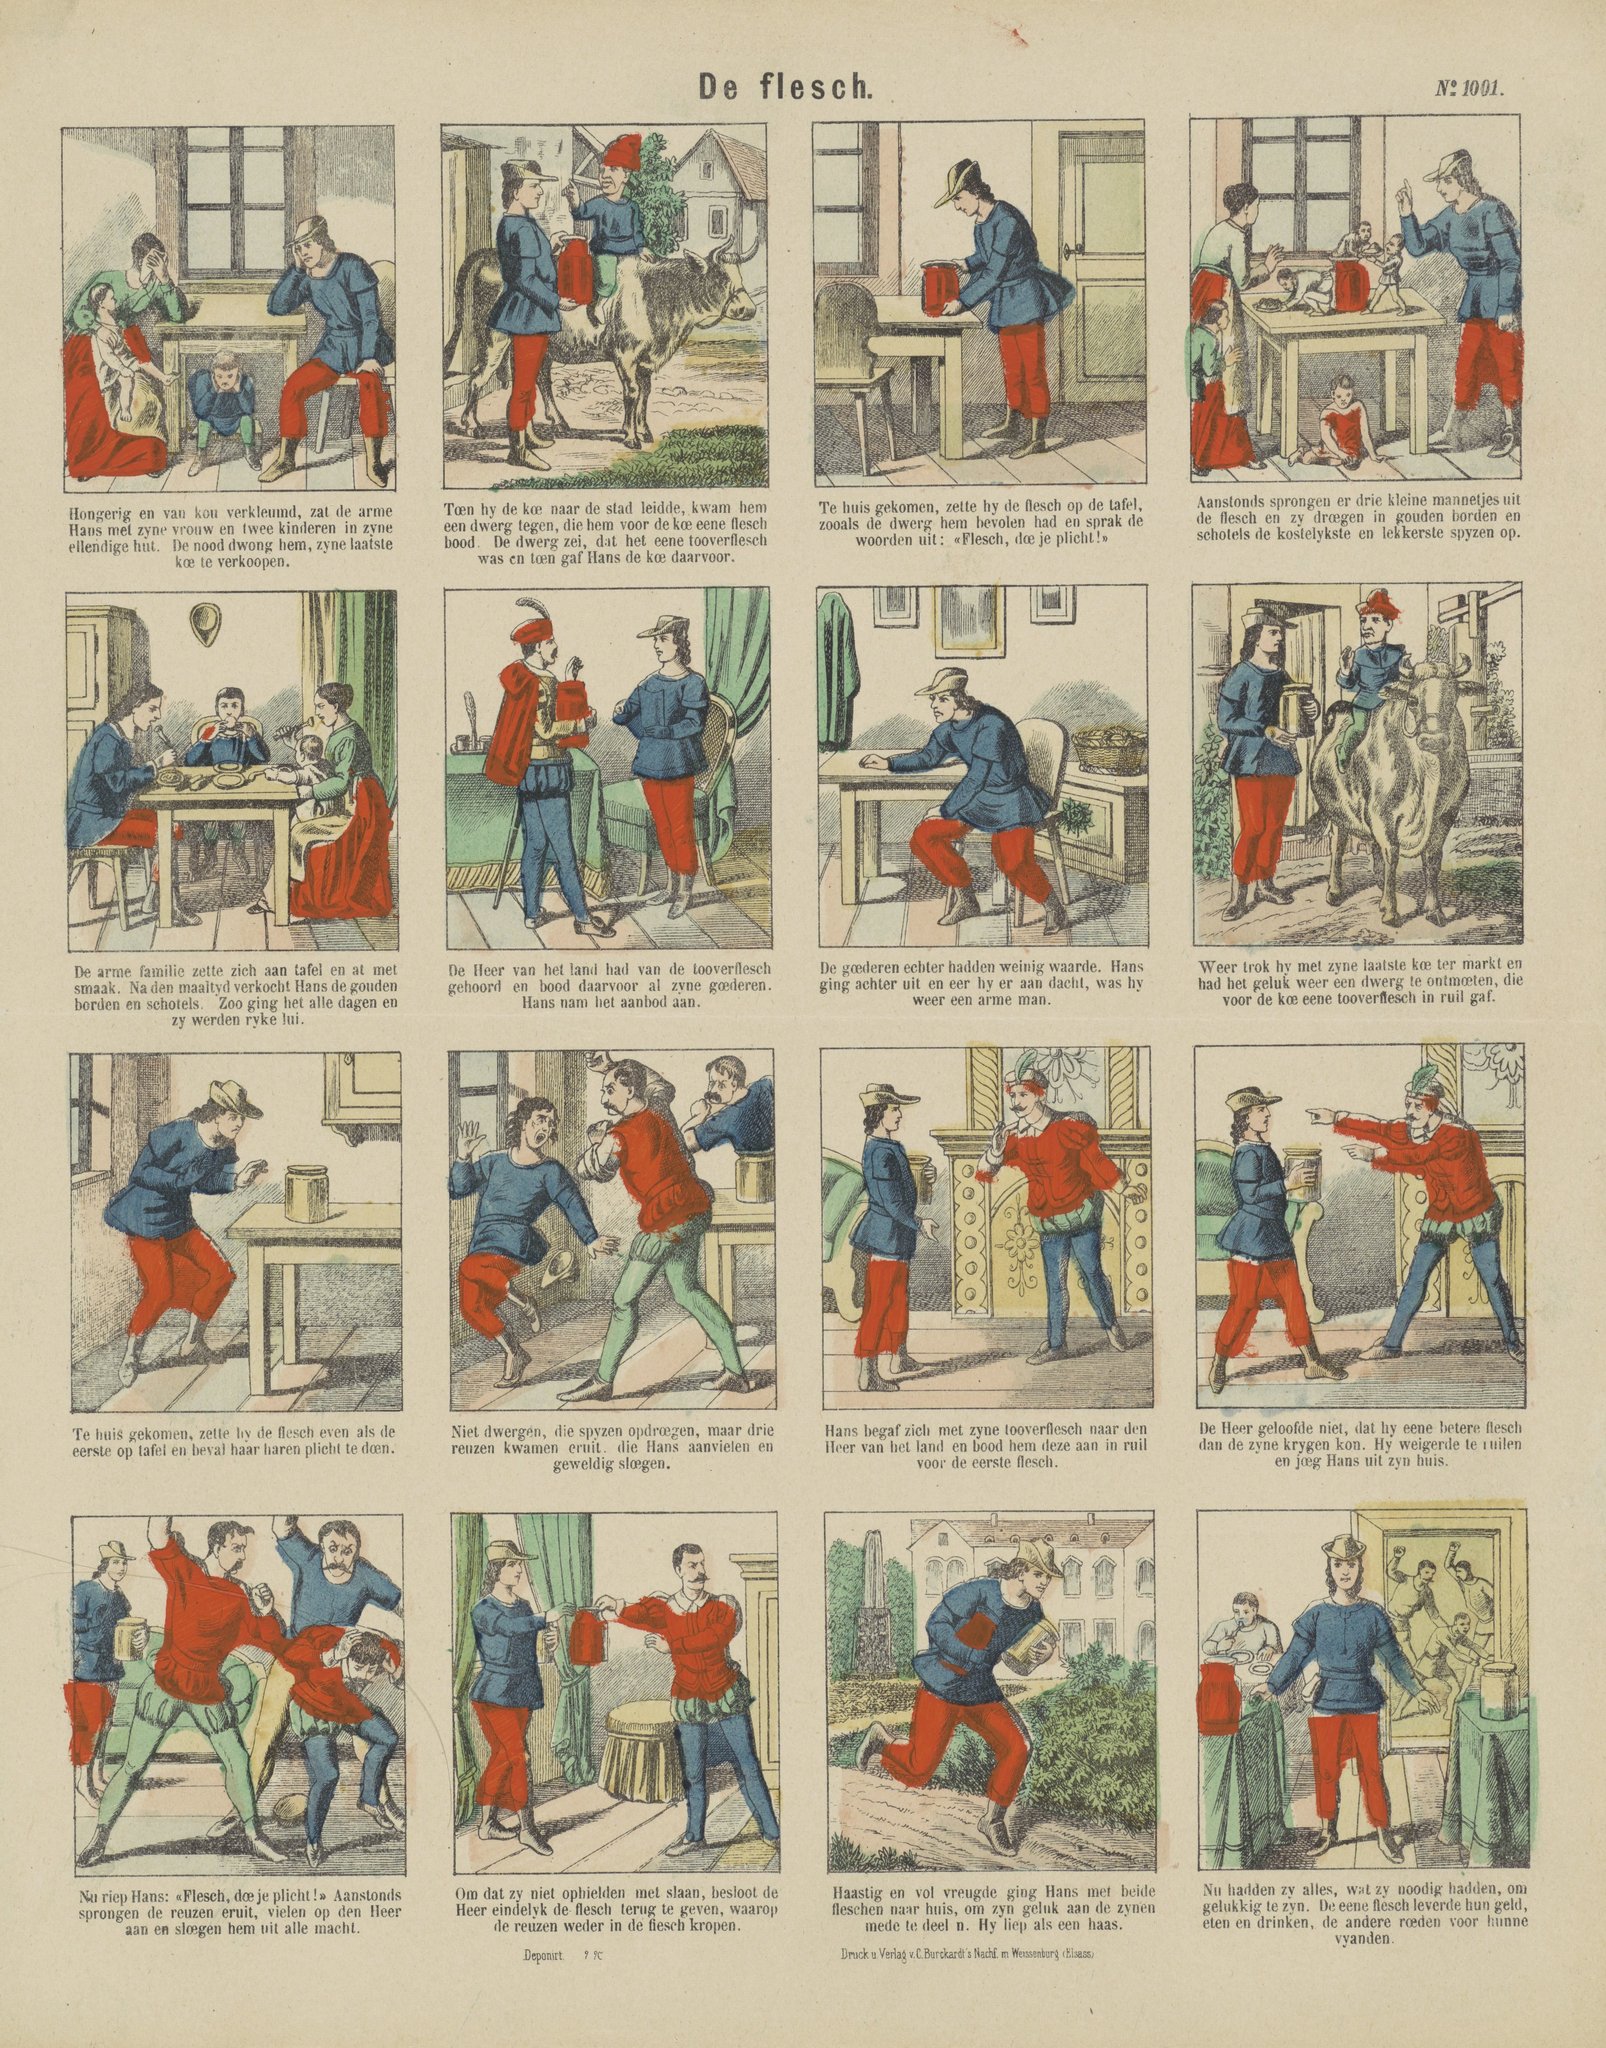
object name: popular print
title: De flesch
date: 1889-1906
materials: paper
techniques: hand coloring, letterpress printing, lithograph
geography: wissembourg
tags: magic, supernaturalism, occultism, tales and fairy tales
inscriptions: collector's mark: Lugt 2760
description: Blad met 16 voorstellingen uit het verhaal van de (tover)fles. Onder elke afbeelding een onderschrift. Genummerd rechtsboven: No. 1001.